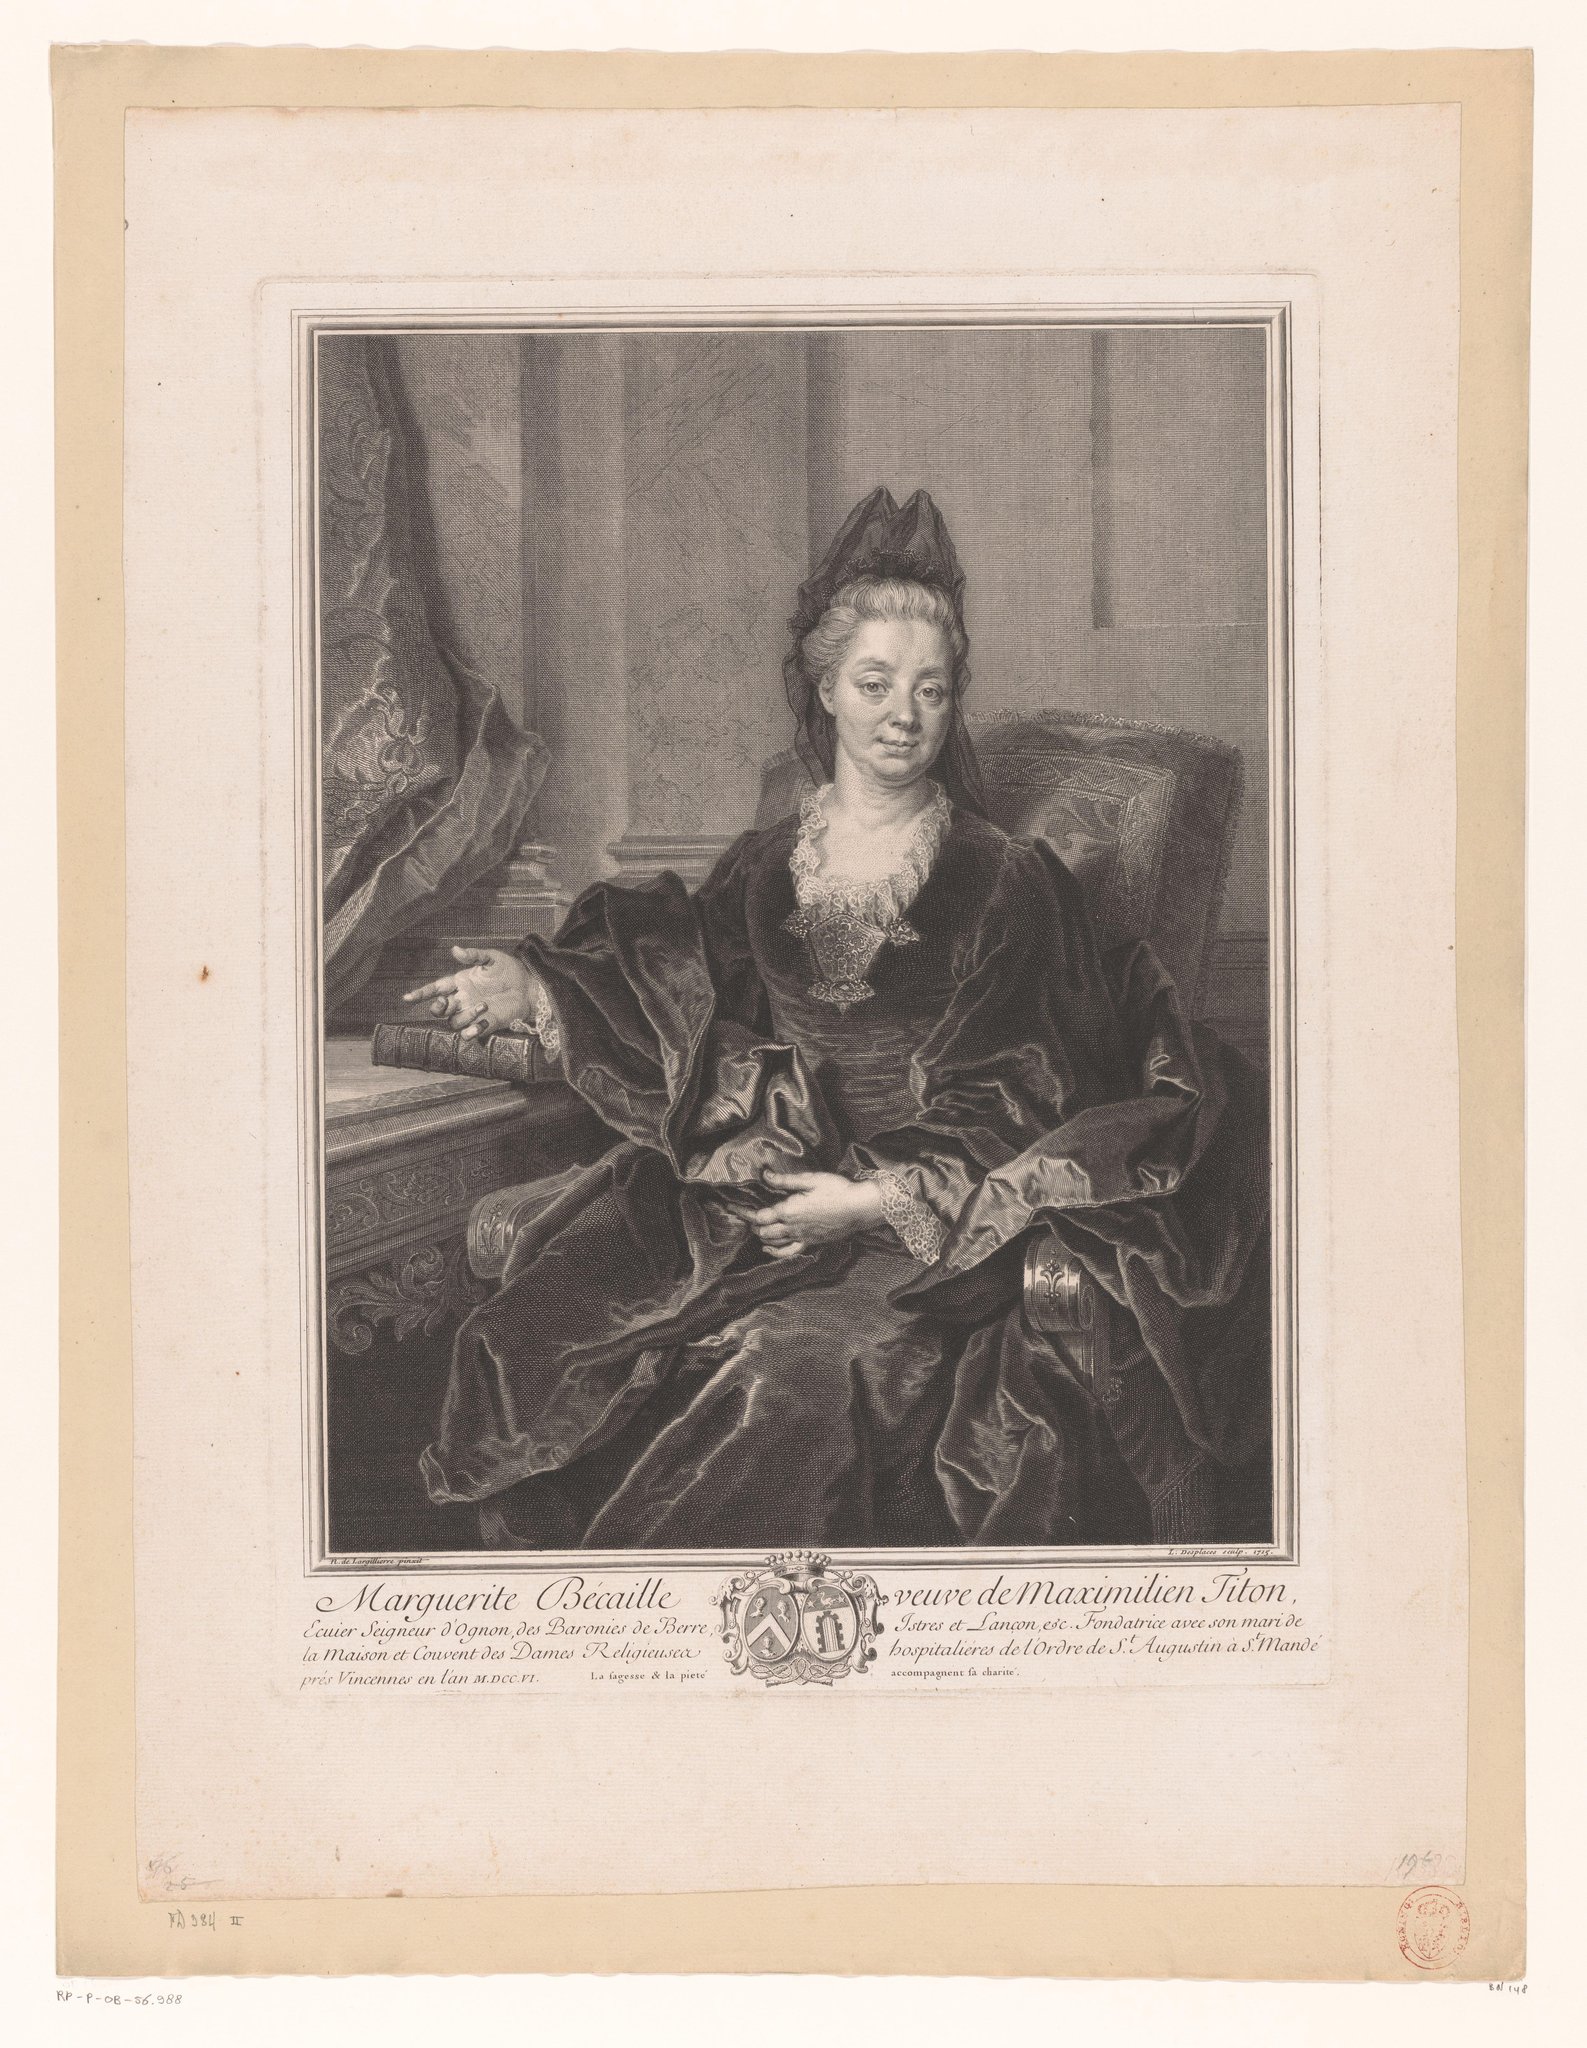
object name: print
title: Portret van Marguerite Bécaille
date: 1715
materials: paper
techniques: engraving, etching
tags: historical persons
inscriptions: collector's mark: Lugt 240